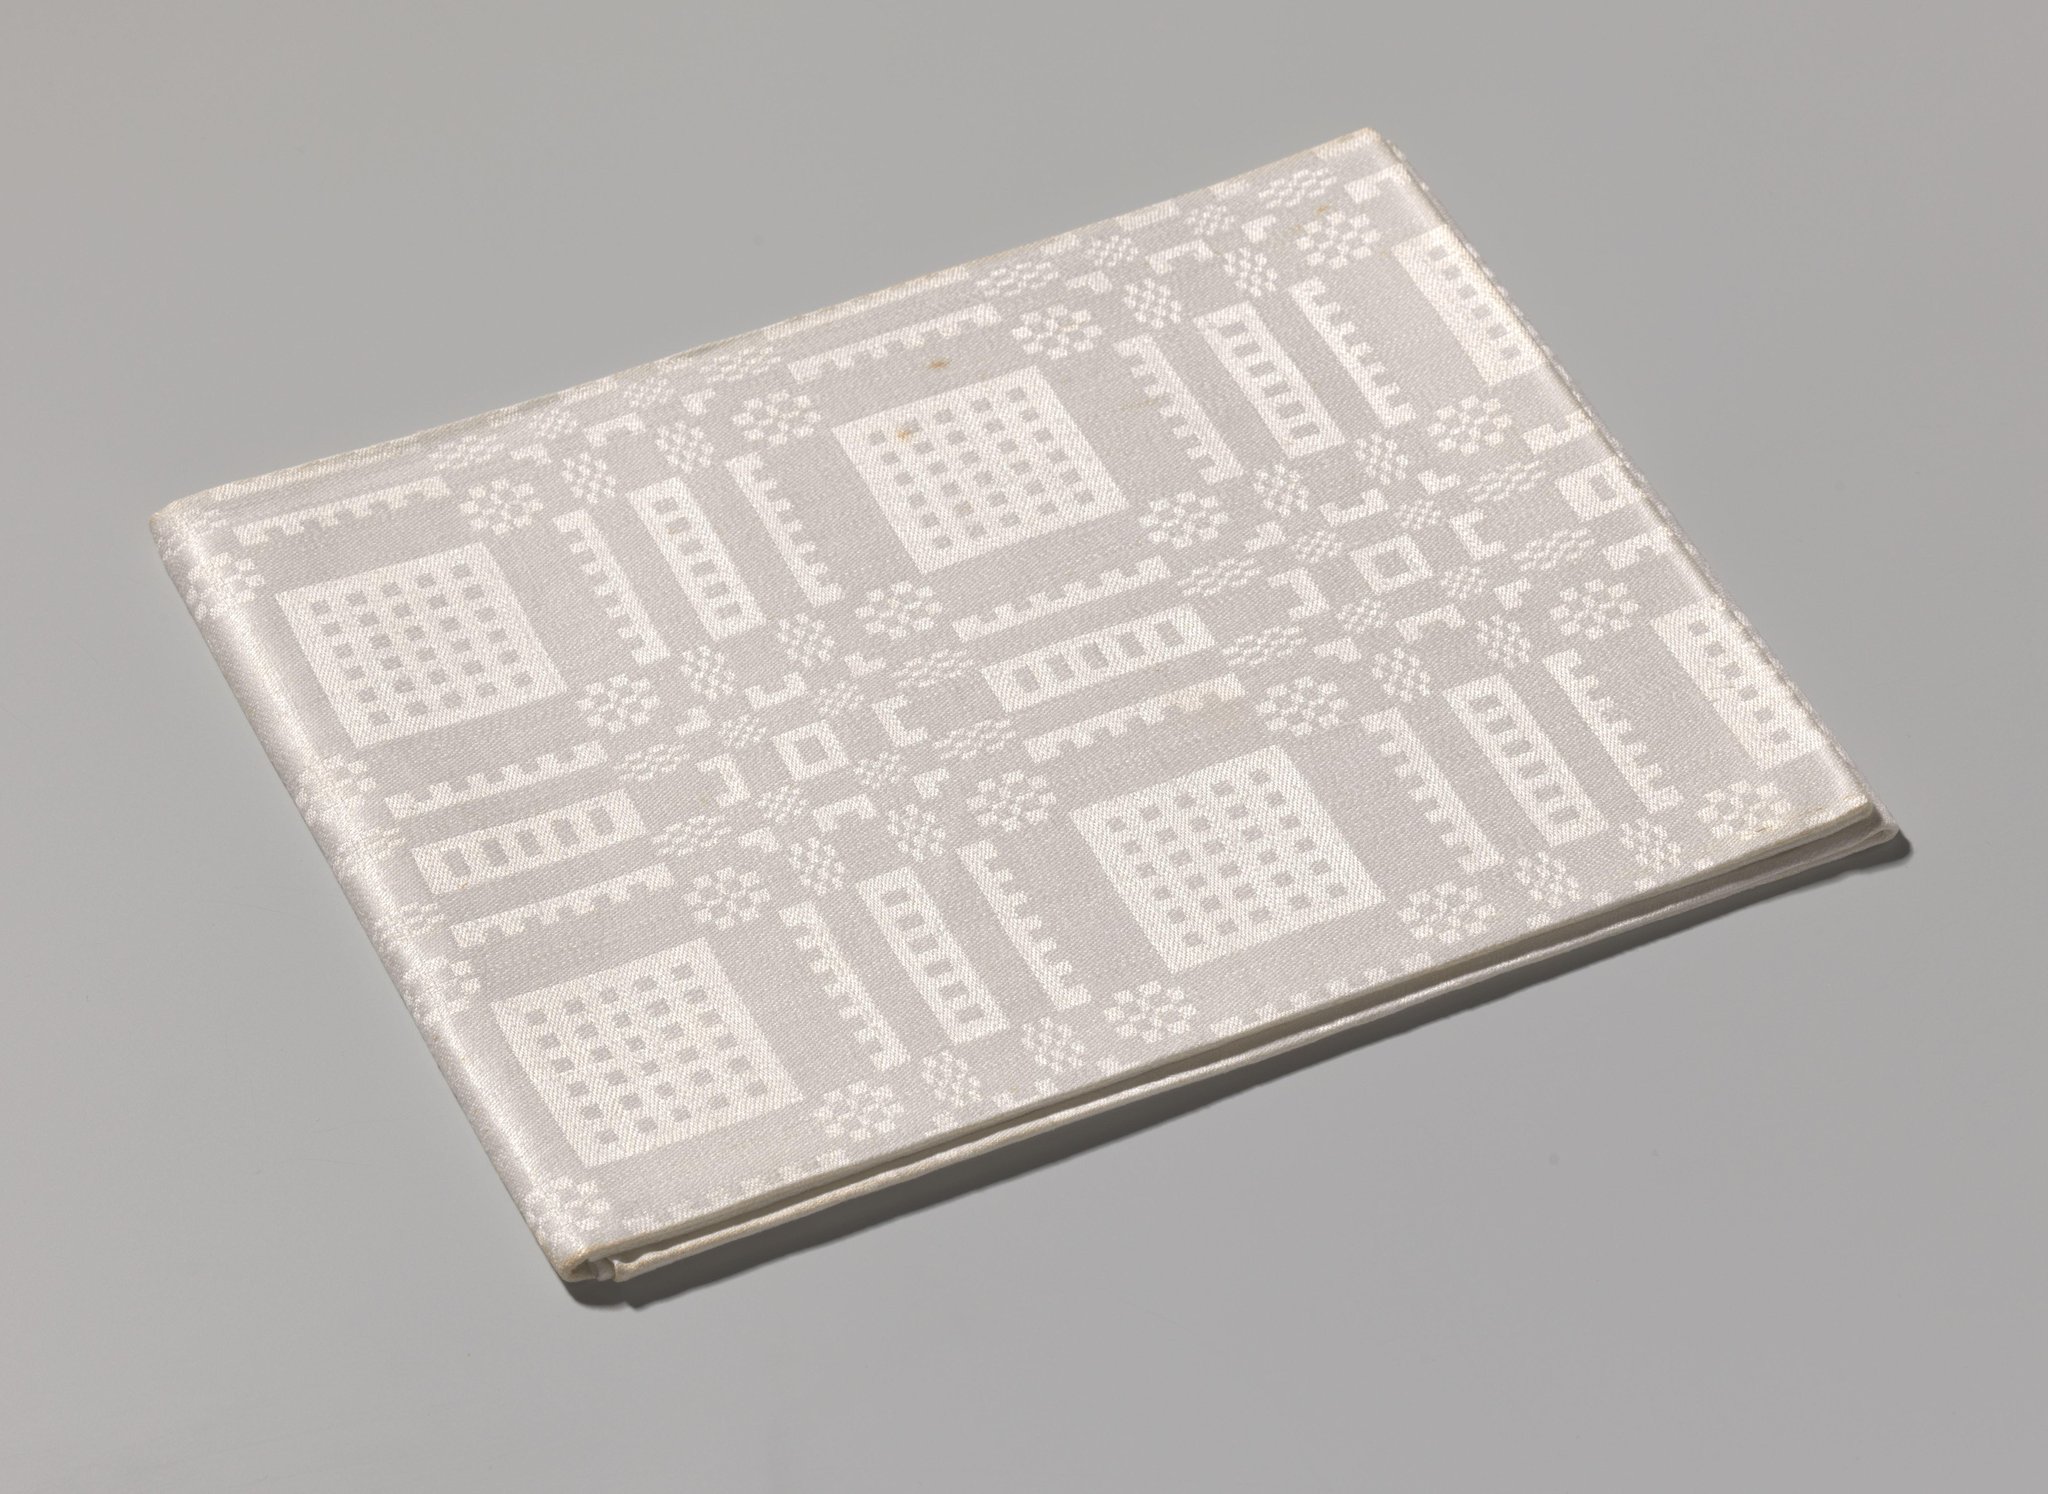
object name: napkin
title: Servet met pellenpatroon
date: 1756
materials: linen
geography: northern netherlands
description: Servet van wit linnen met pellenpatroon, merk kroon G 30 en 1756.